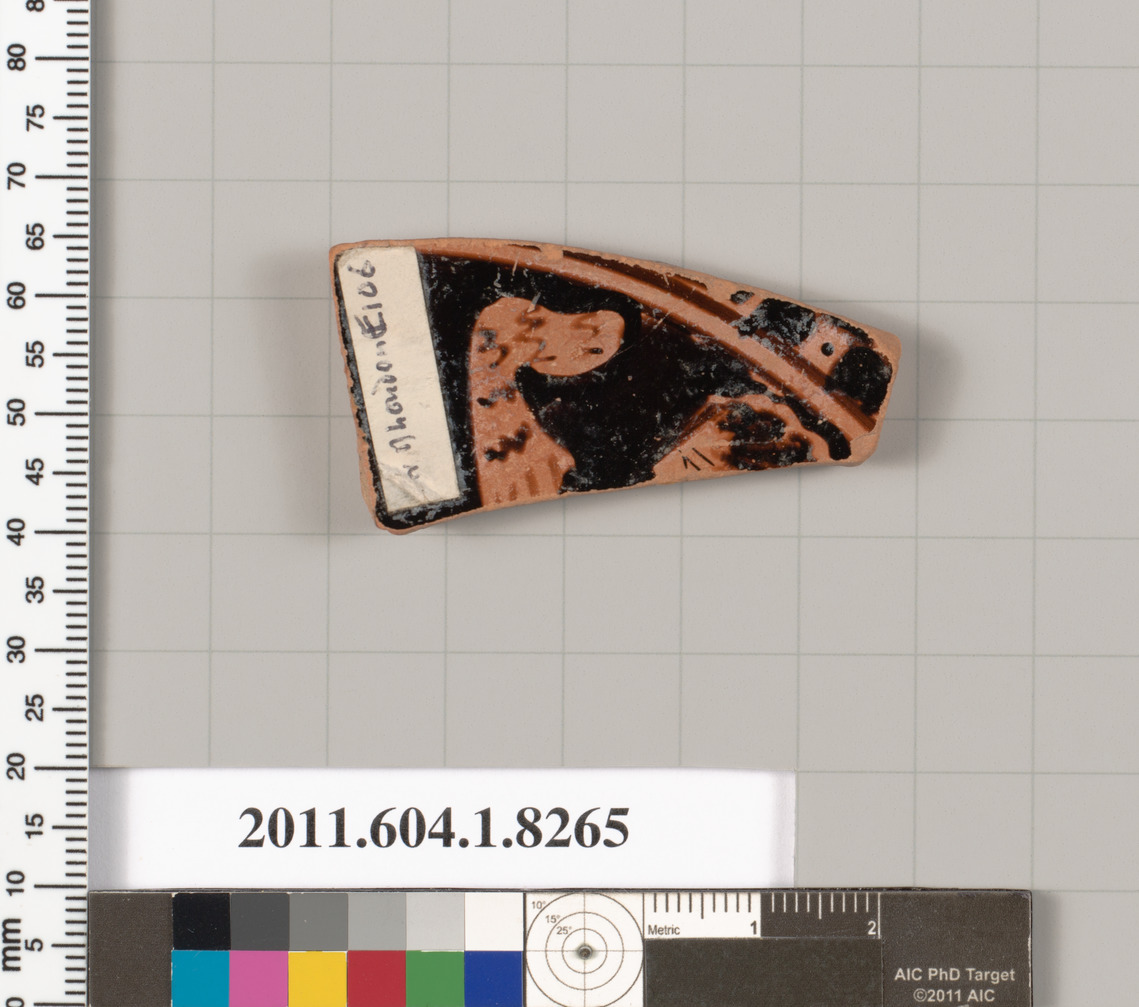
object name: kylix fragment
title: Terracotta fragment of a kylix (drinking cup)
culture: greek, attic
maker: painter of london e 106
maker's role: artist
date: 410-400 BCE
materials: terracotta